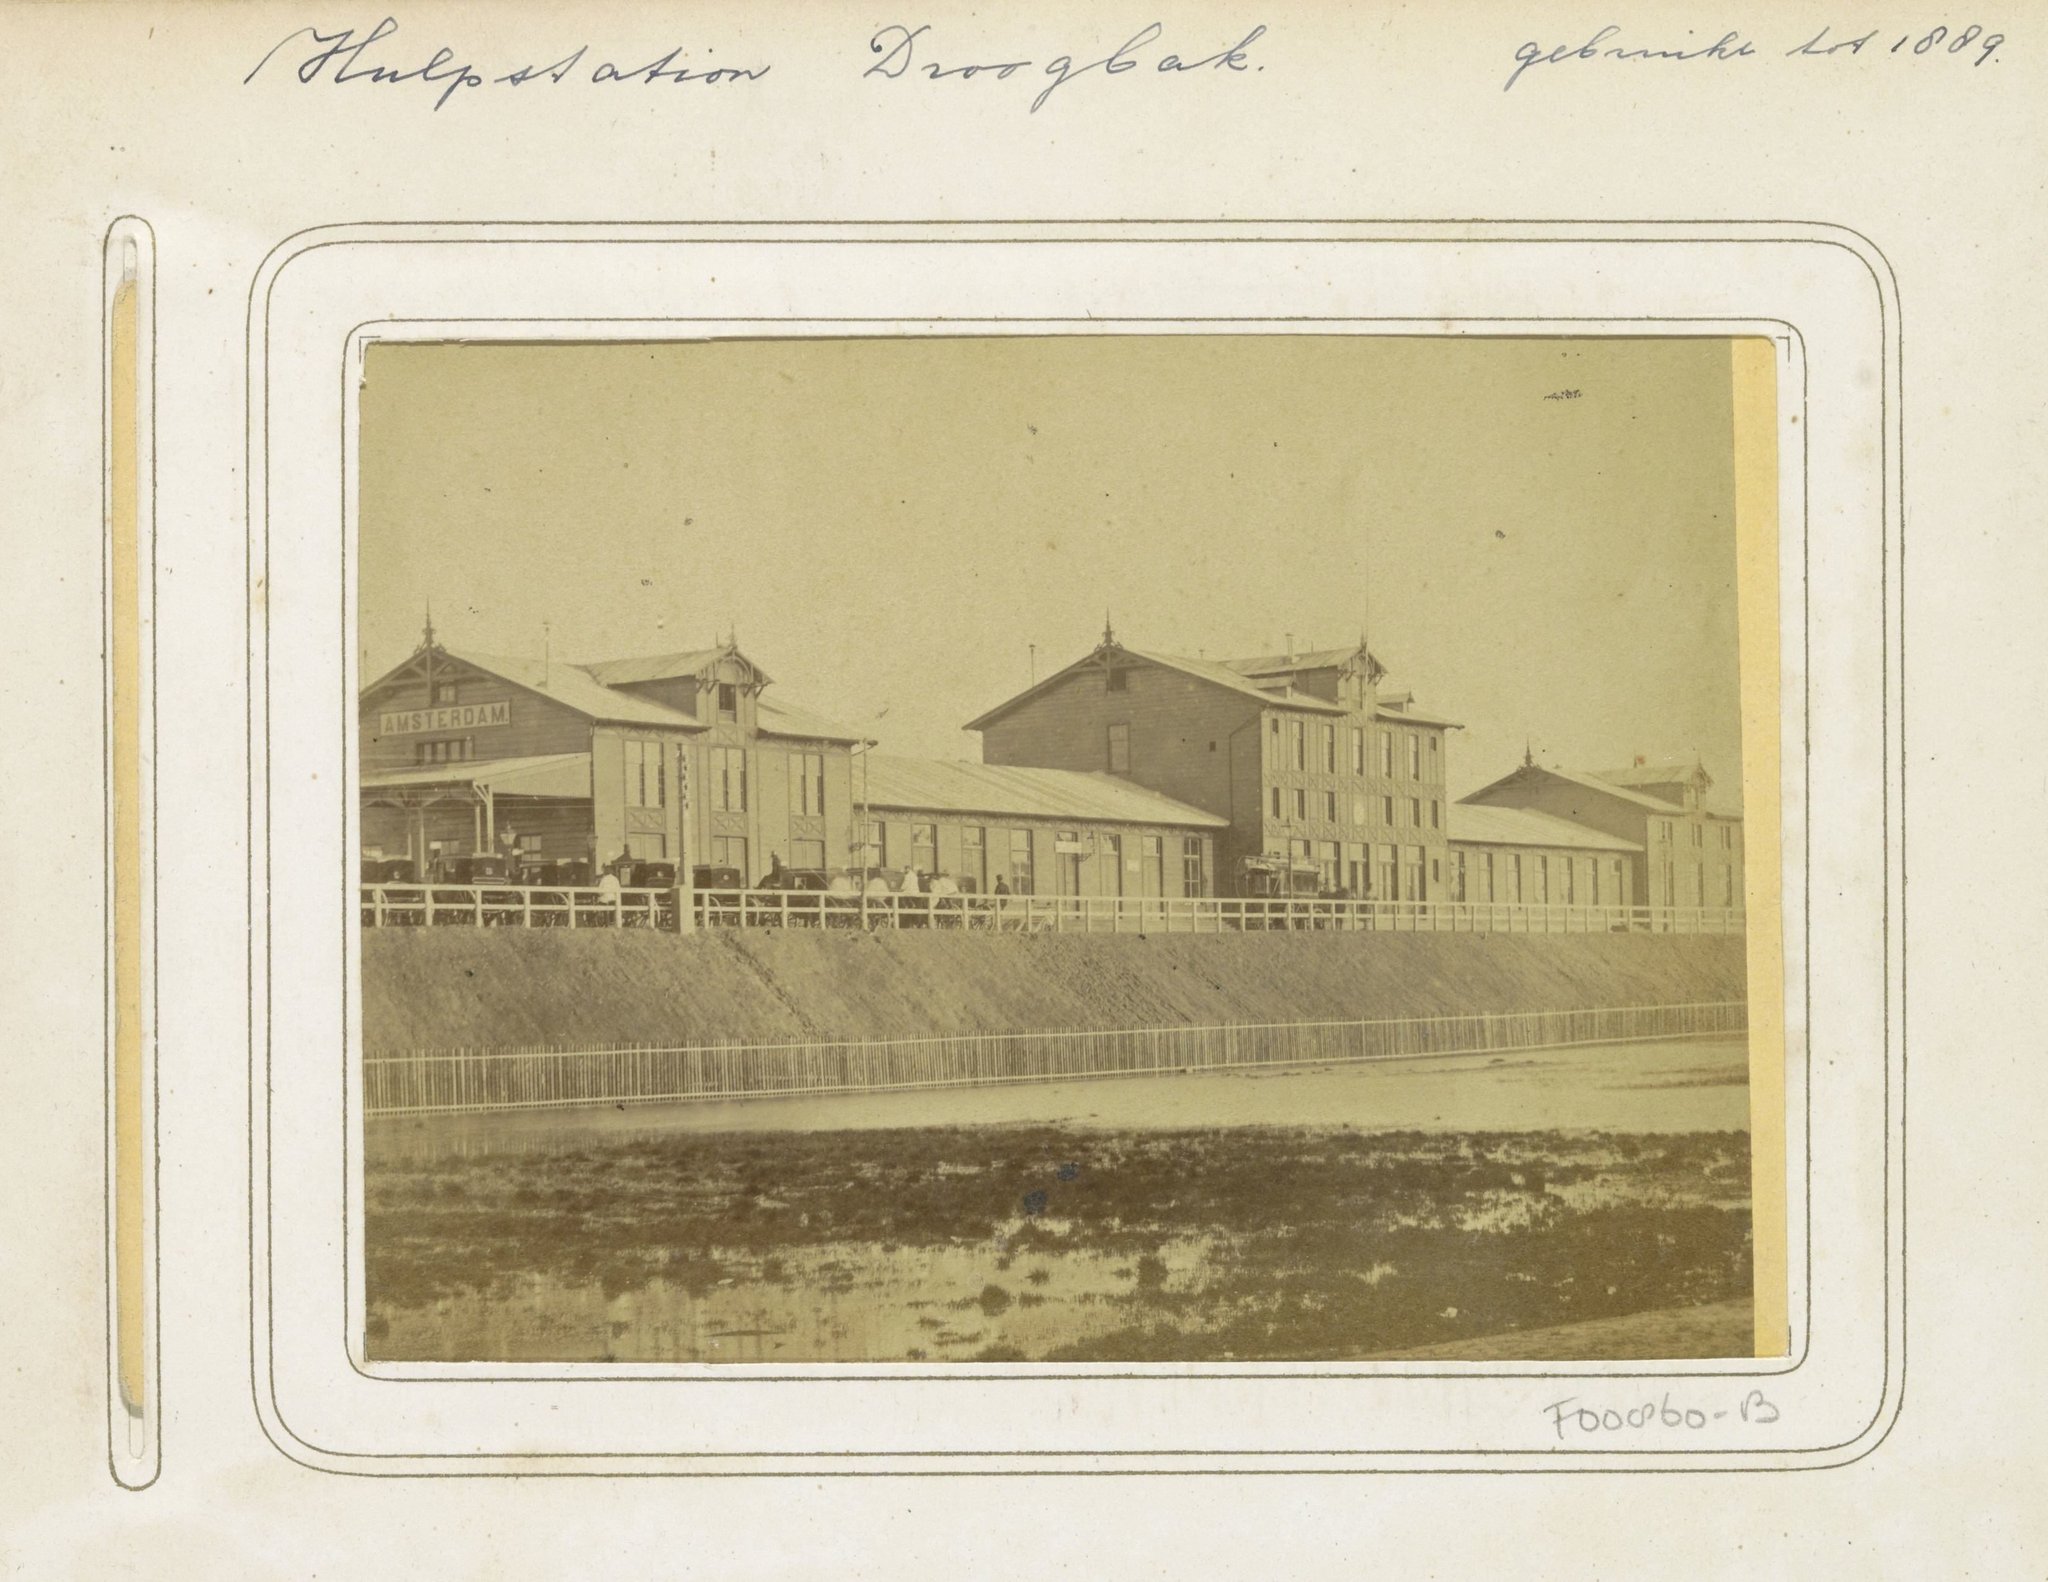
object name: cabinet photograph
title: Exterieur van hulpstation Westerdok aan de Droogbak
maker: Anonymous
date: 1879-1889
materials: cardboard, paper, photographic support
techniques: albumen print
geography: amsterdam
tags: station; shelter (railway, tramway), prospect of city, town panorama, silhouette of city, amsterdam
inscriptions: inscription: ‘Hulpstation Droogbak Amsterdam.’